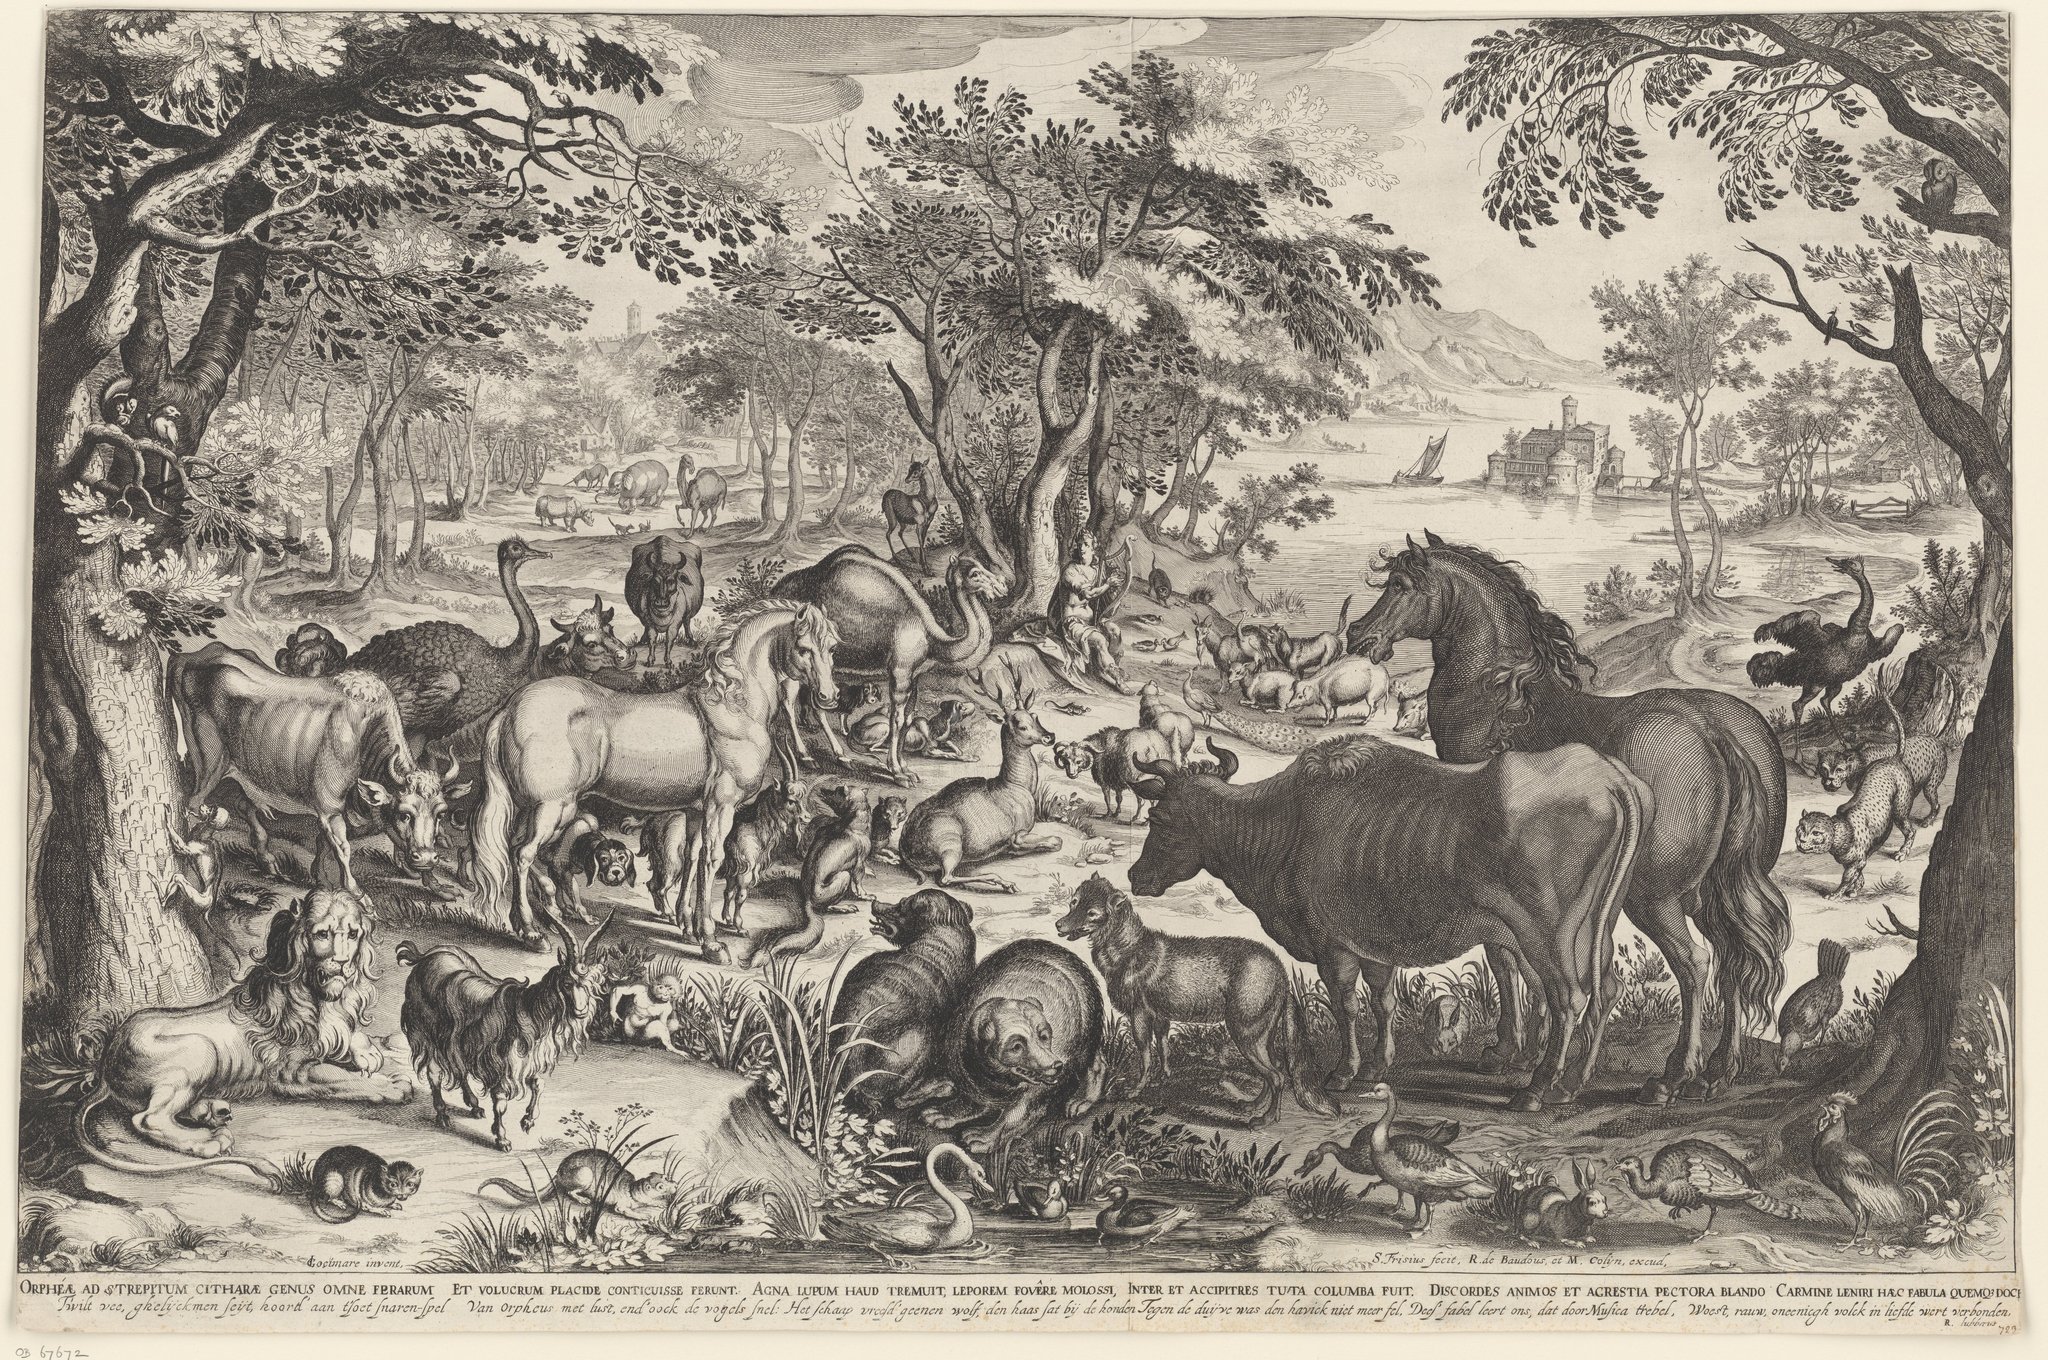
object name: print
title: Orpheus betovert de dieren met zijn muziek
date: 1618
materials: paper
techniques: engraving, etching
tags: orpheus playing the lyre: trees and rocks move, beasts and birds are enchanted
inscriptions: collector's mark: Lugt 240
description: Orpheus zit onder een boom in het midden van een landschap en tokkelt op zijn lier. Allerlei dieren, wilde en tamme, zitten vreedzaam om hem heen. In de marge onder de prent staan twee regels tekst in het Latijn en Nederlands.